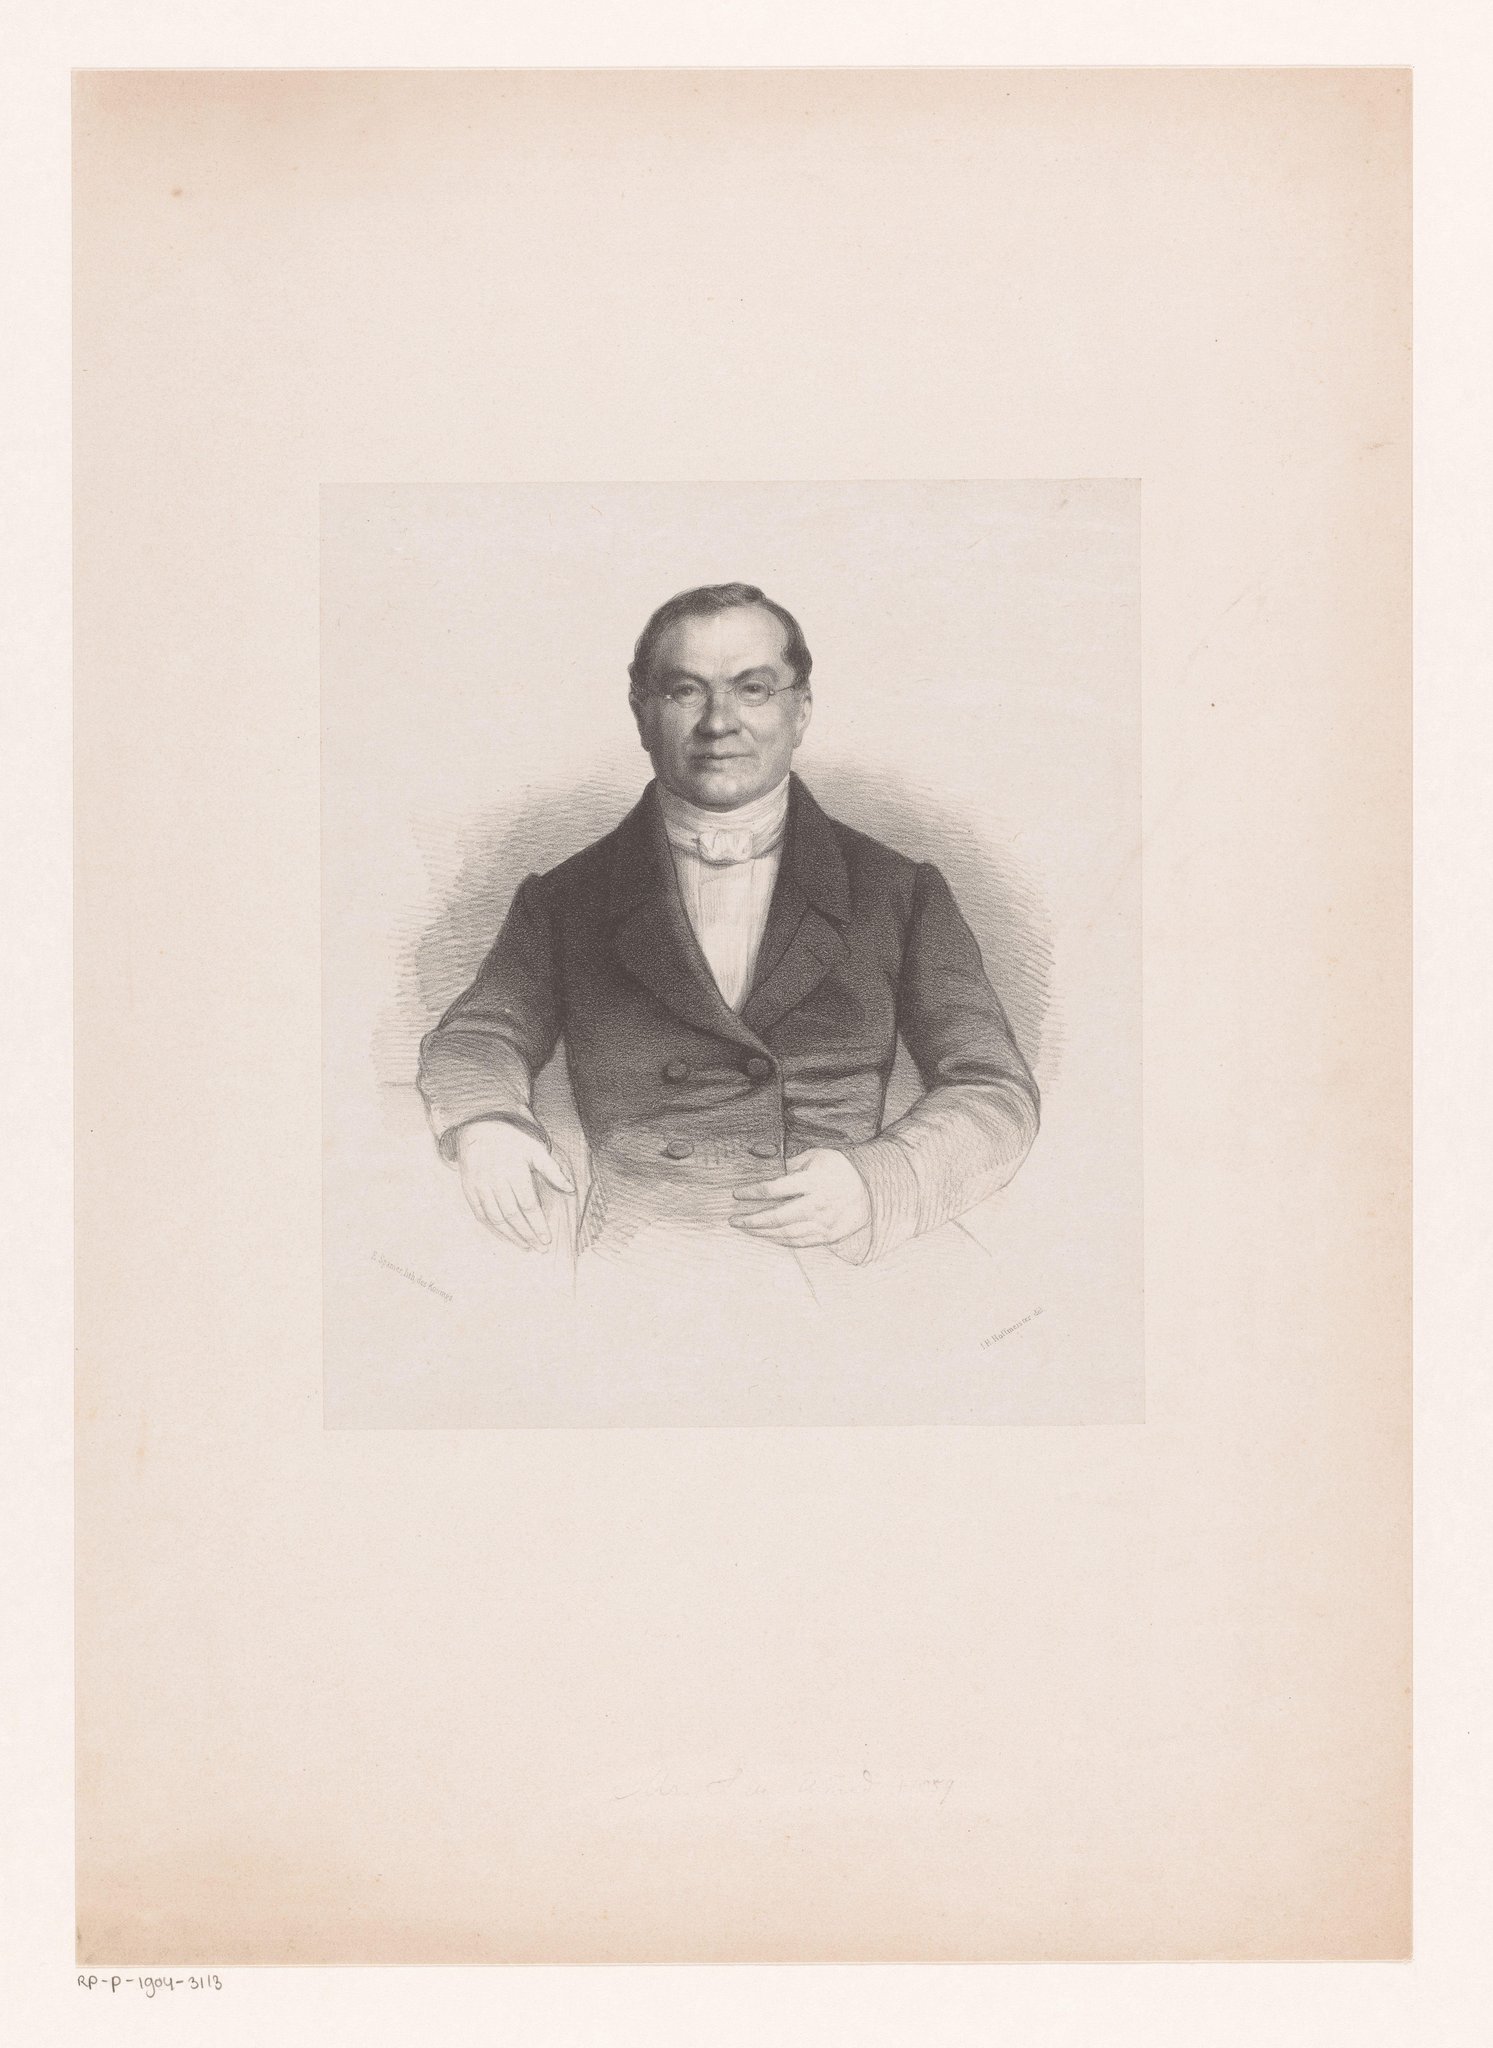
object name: print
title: Portret van een onbekende man met bril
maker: johan hendrik hoffmeister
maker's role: print maker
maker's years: 1823-1904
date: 1851-1883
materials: paper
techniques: lithograph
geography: netherlands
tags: eyeglasses, spectacles, historical persons (+ half-length portrait)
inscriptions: collector's mark: Lugt 2228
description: De geportretteerde heeft de duim van zijn linkerhand in zijn jas gestoken.